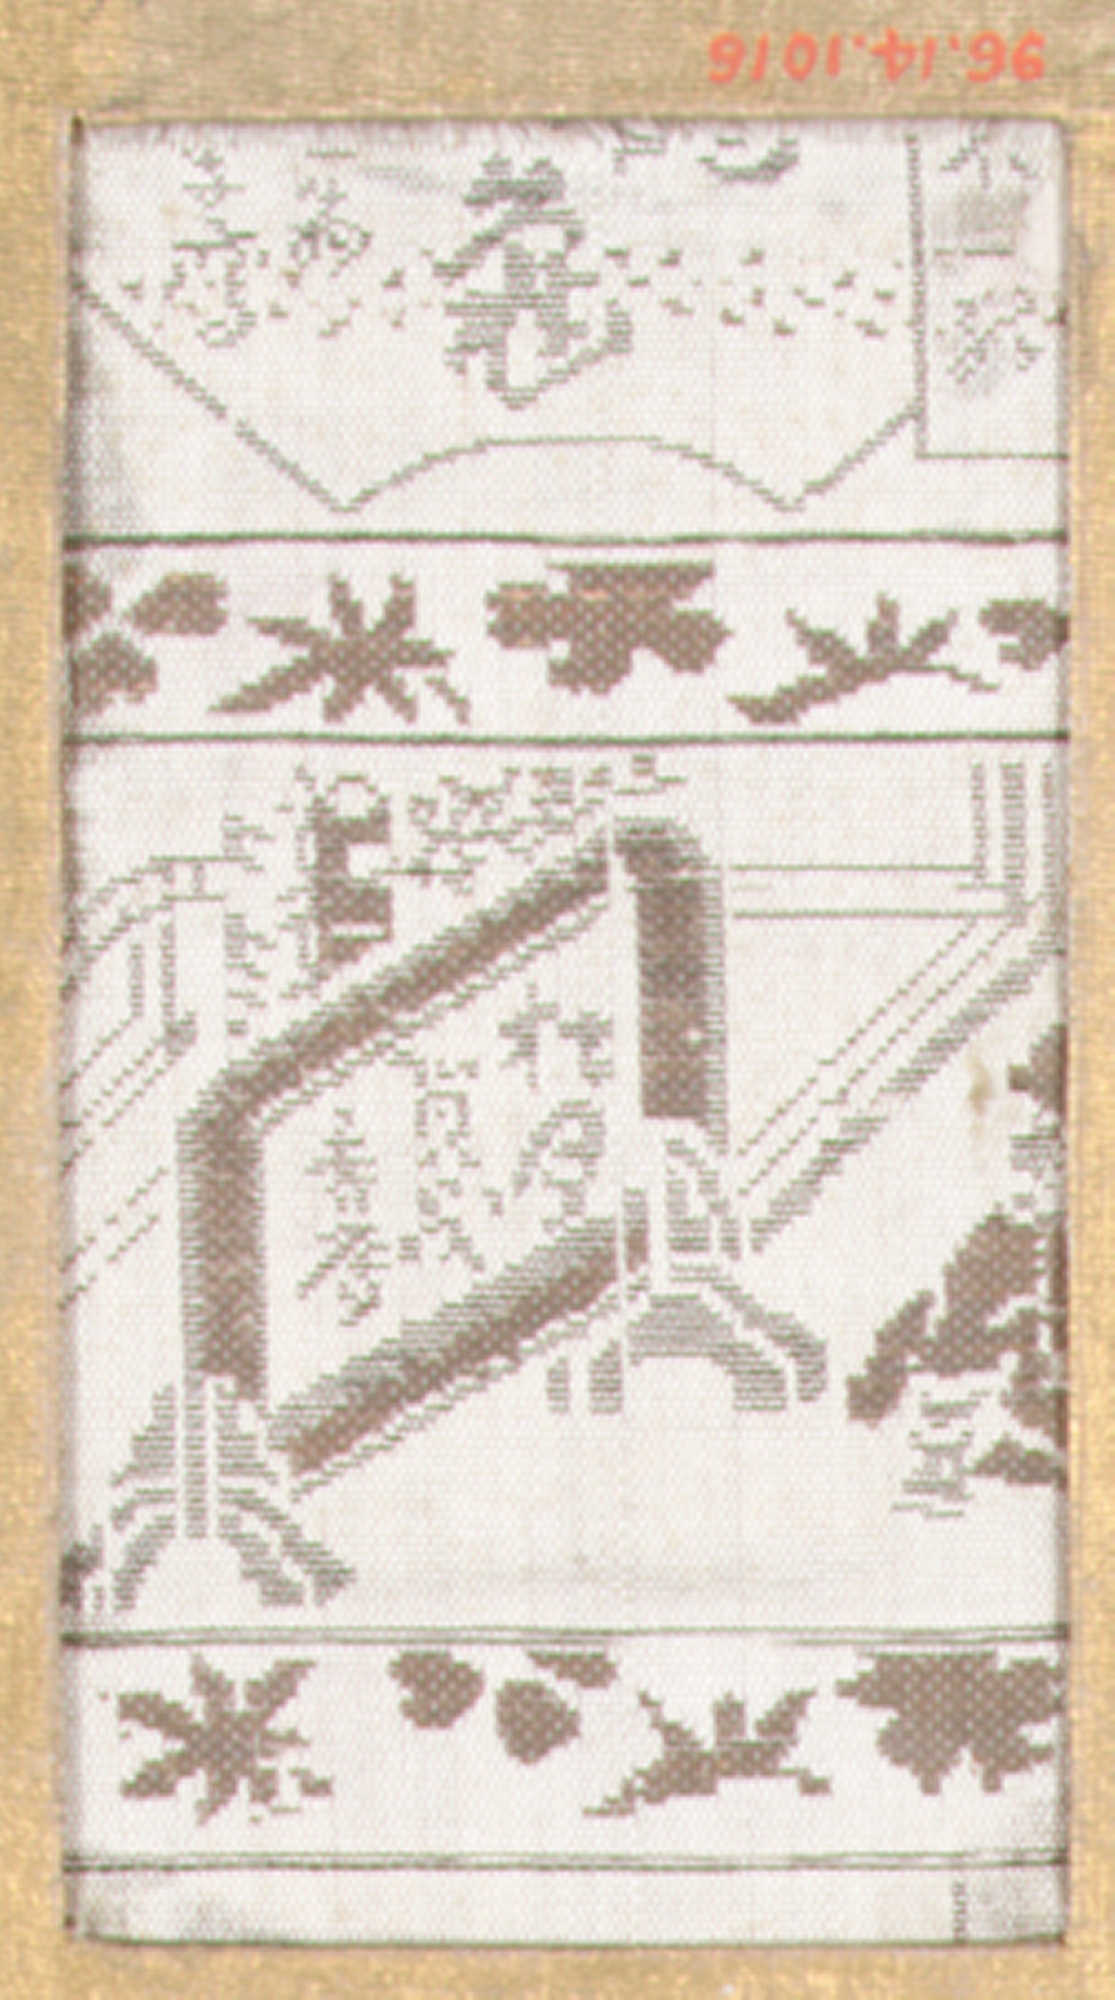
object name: piece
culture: japanese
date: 1701-1900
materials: silk